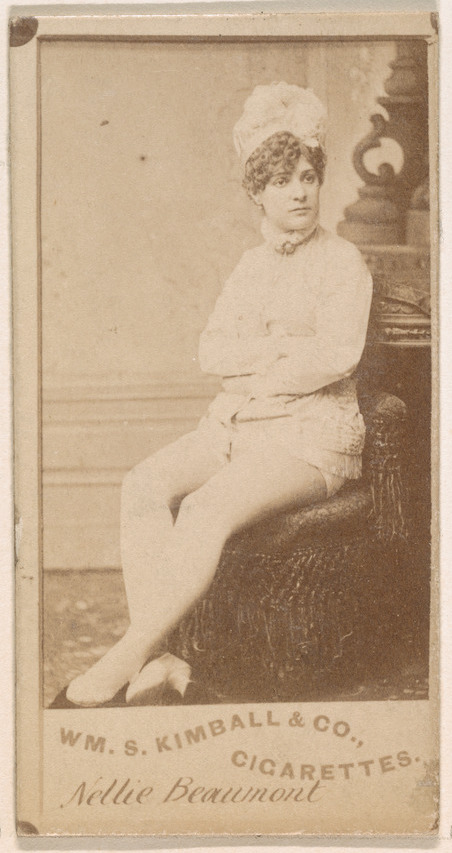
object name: photograph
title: Nellie Beaumont, from the Actresses series (N203) issued by Wm. S. Kimball & Co.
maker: william s. kimball & company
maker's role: publisher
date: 1889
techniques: color lithograph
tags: portraits,women,actresses